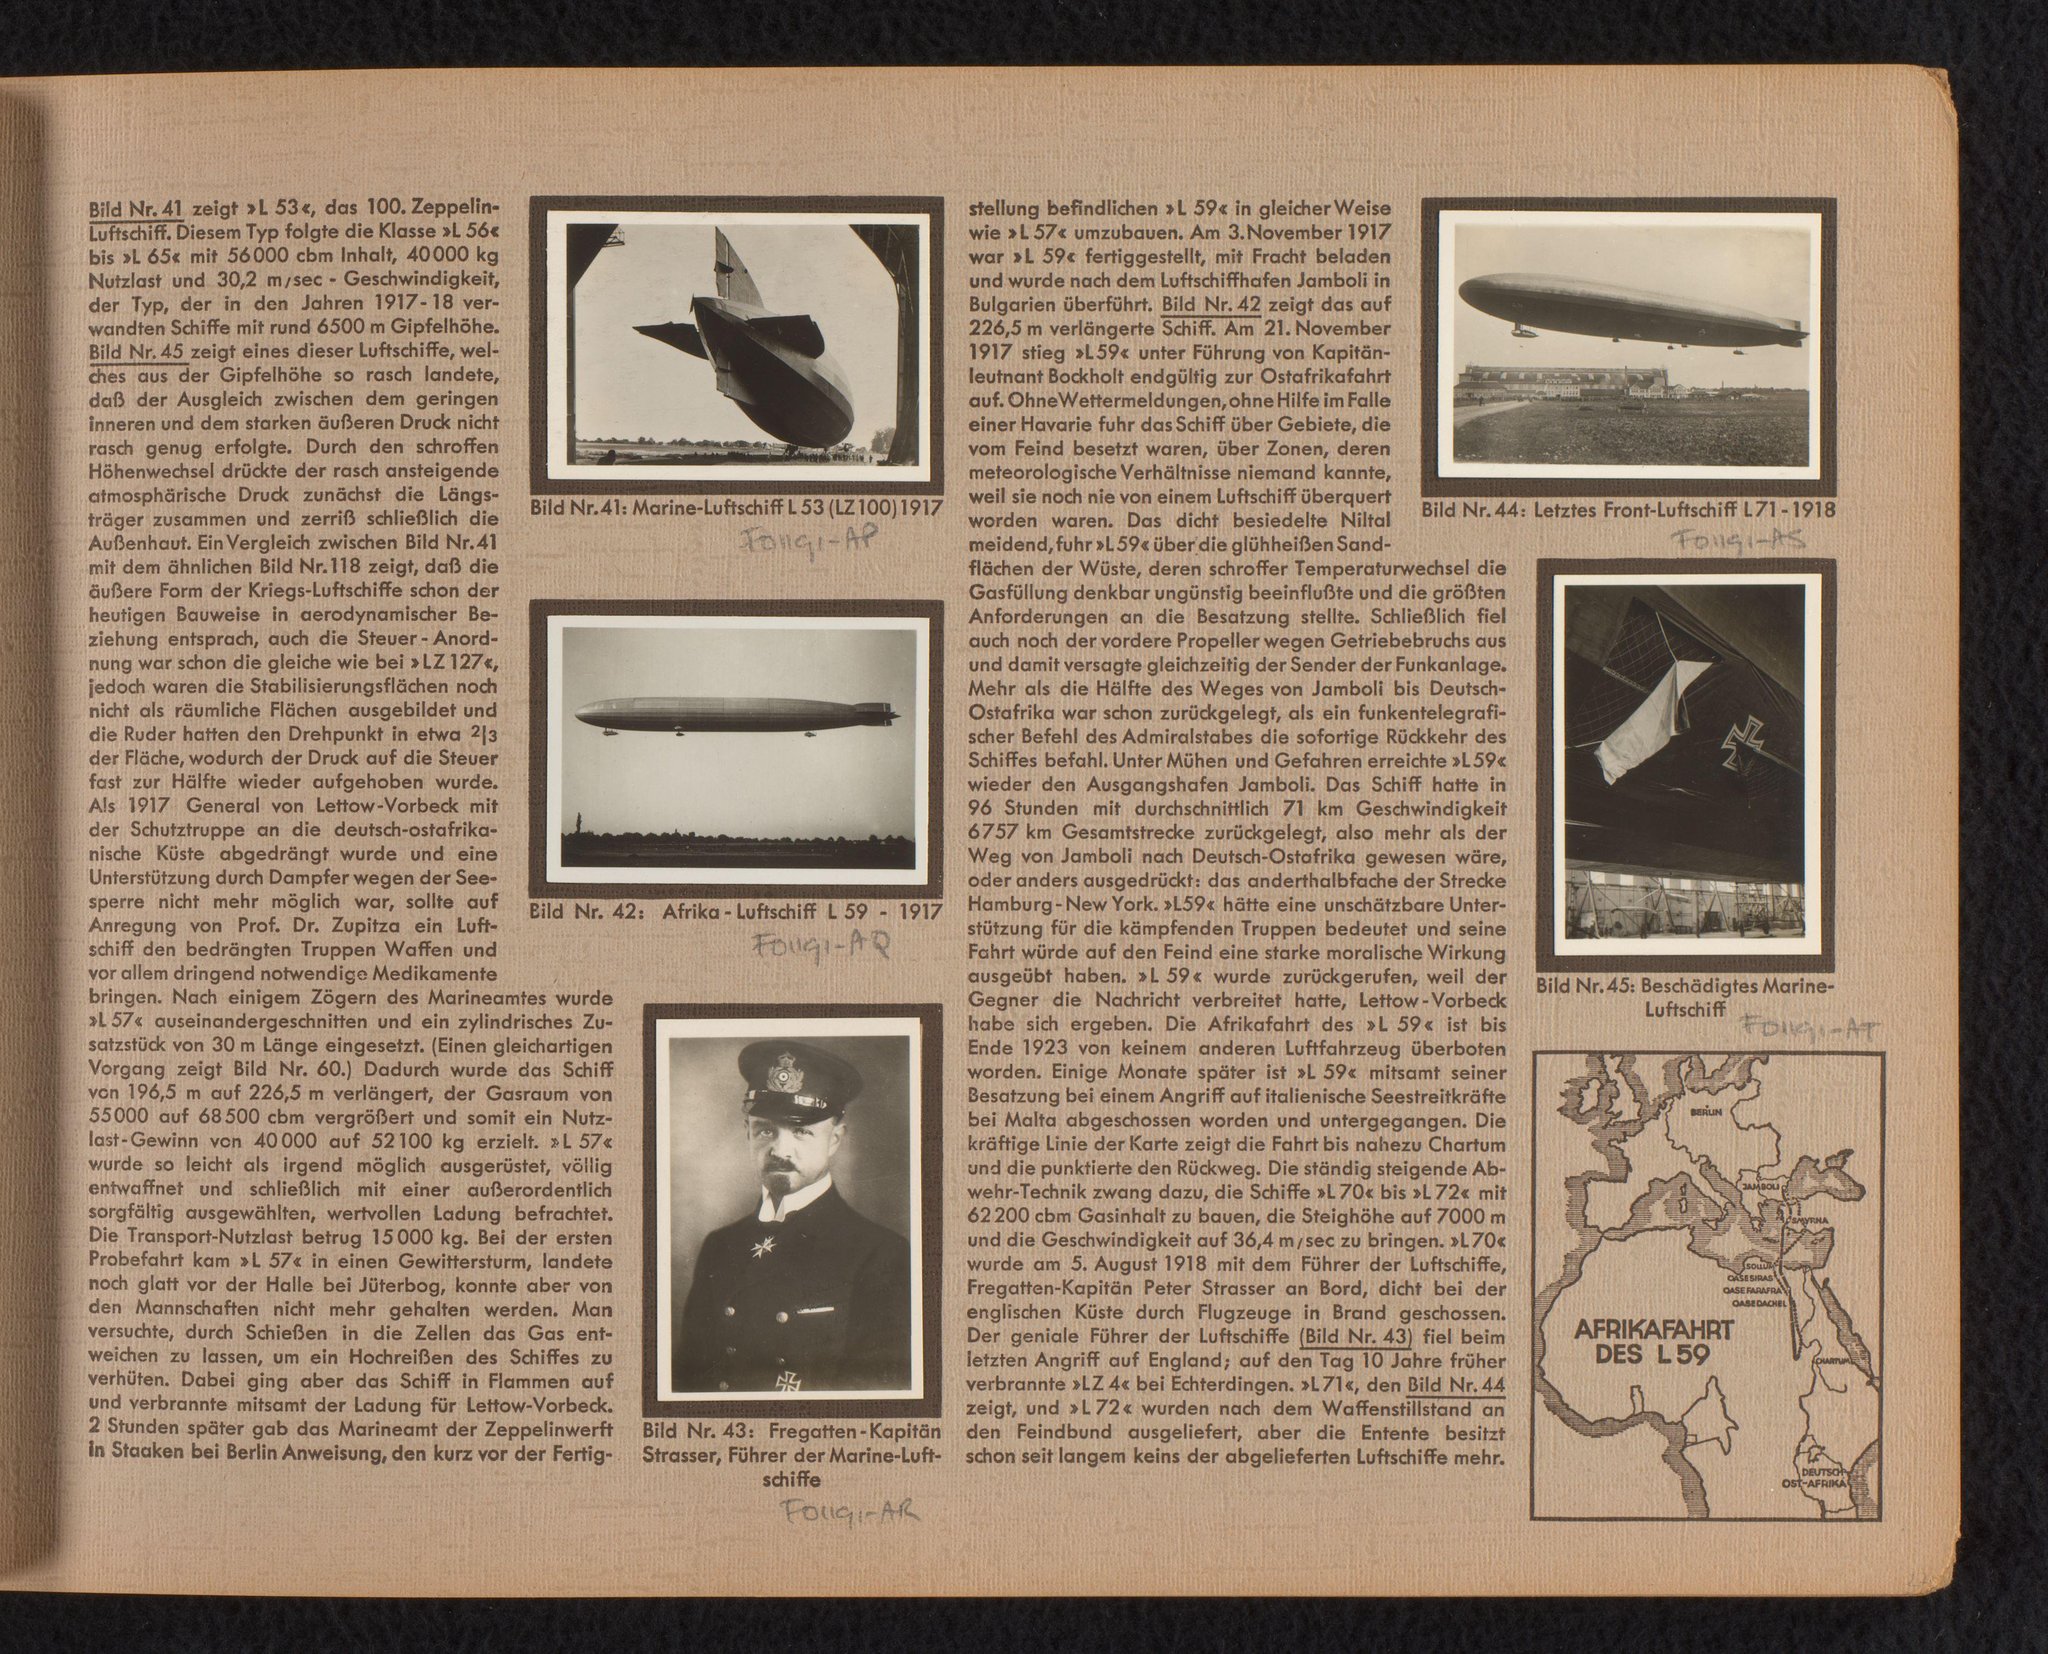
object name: scrapbook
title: Zeppelins tijdens de Eerste Wereldoorlog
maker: Anonymous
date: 1917-1918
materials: paper, photographic support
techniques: gelatin silver print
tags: 46c35 airship, zeppelin, historical persons, (military) uniforms, germany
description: Vijf foto's van onder meer zeppelins tijdens de Eerste Wereldoorlog en een portret van Peter Strasser. Alle foto's zijn voorzien van een nummer en titel. Deze pagina maakt deel uit van een album.